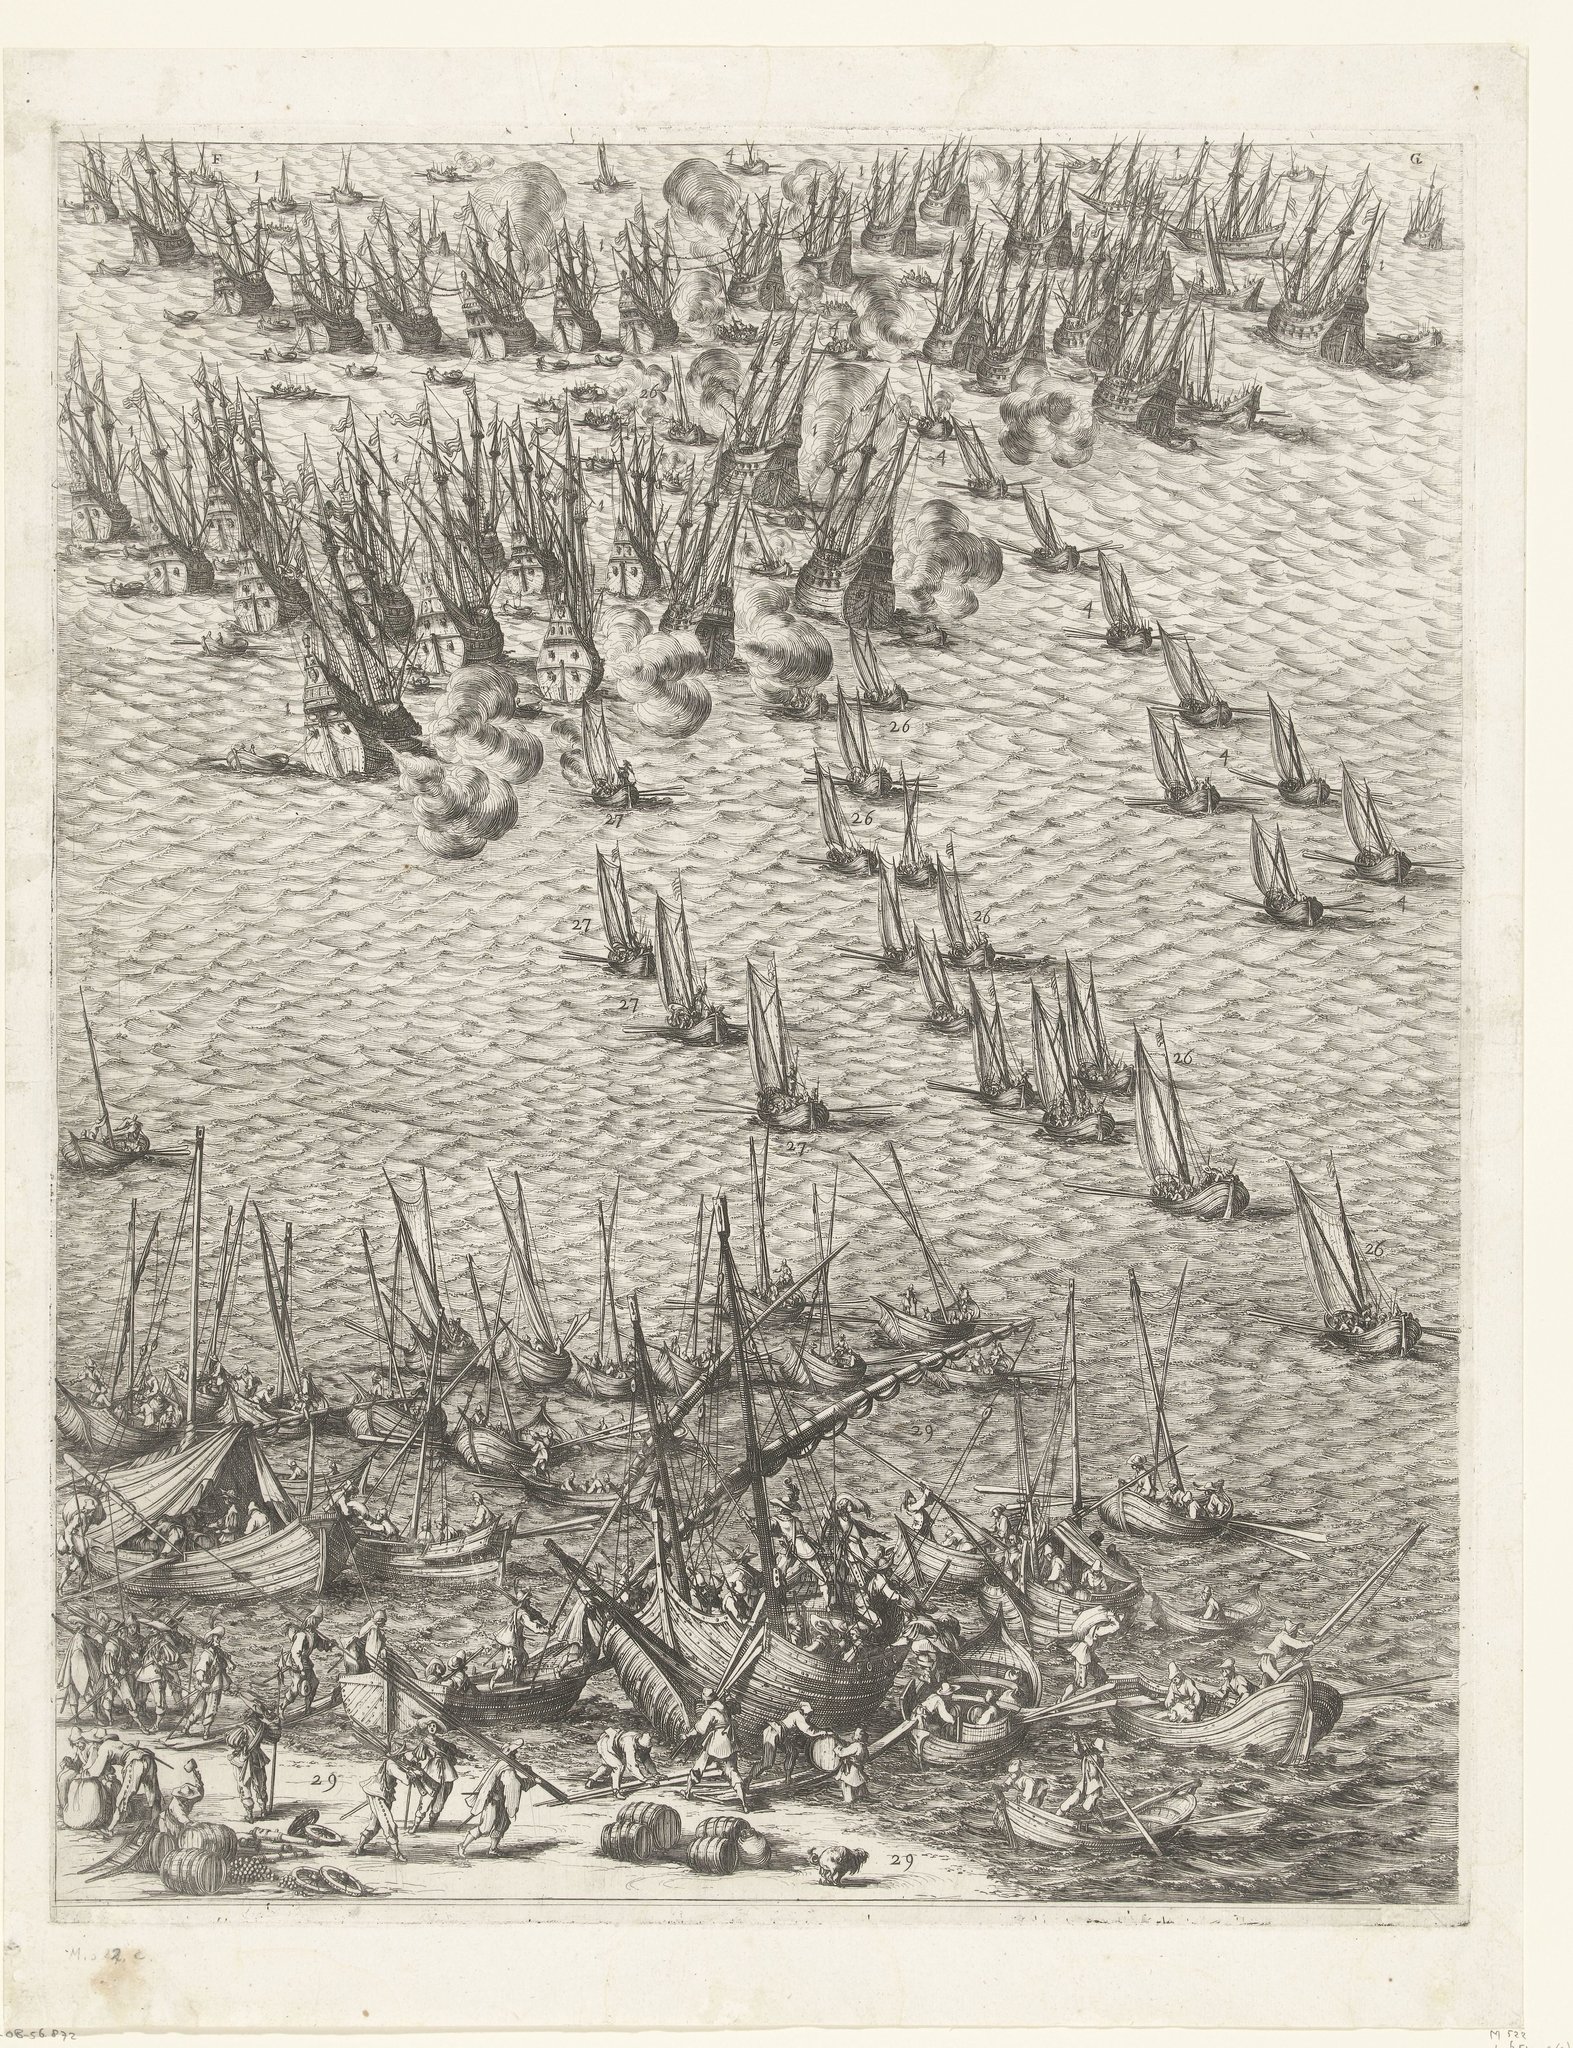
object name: history print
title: Beleg van Saint Martin op het Île de Ré, juli-november 1627 (centrale kaart, deel middenonder)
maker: jacques callot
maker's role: draughtsman, print maker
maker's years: 1592-1635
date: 1629-1631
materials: paper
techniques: etching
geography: paris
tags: maps of separate countries or regions, battle, ships (in general), warfare; military affairs (+ naval force), siege, france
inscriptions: collector's mark: Lugt 240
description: Zestiende deel (centrale kaart, deel middenonder) van een prent van het beleg van de citadel Saint Martin op het Île de Ré in 1627, dat werd uitgevoerd door Engelse troepen onder leiding van de hertog van Buckingham en werd beëindigd door Franse troepen onder leiding van kardinaal Richelieu. Op dit blad op de voorgrond de Franse kust, waar goederen worden ingescheept voor de overtocht naar het Île de Ré. Op de achtergrond gevechten tussen Engelse en Franse schepen.